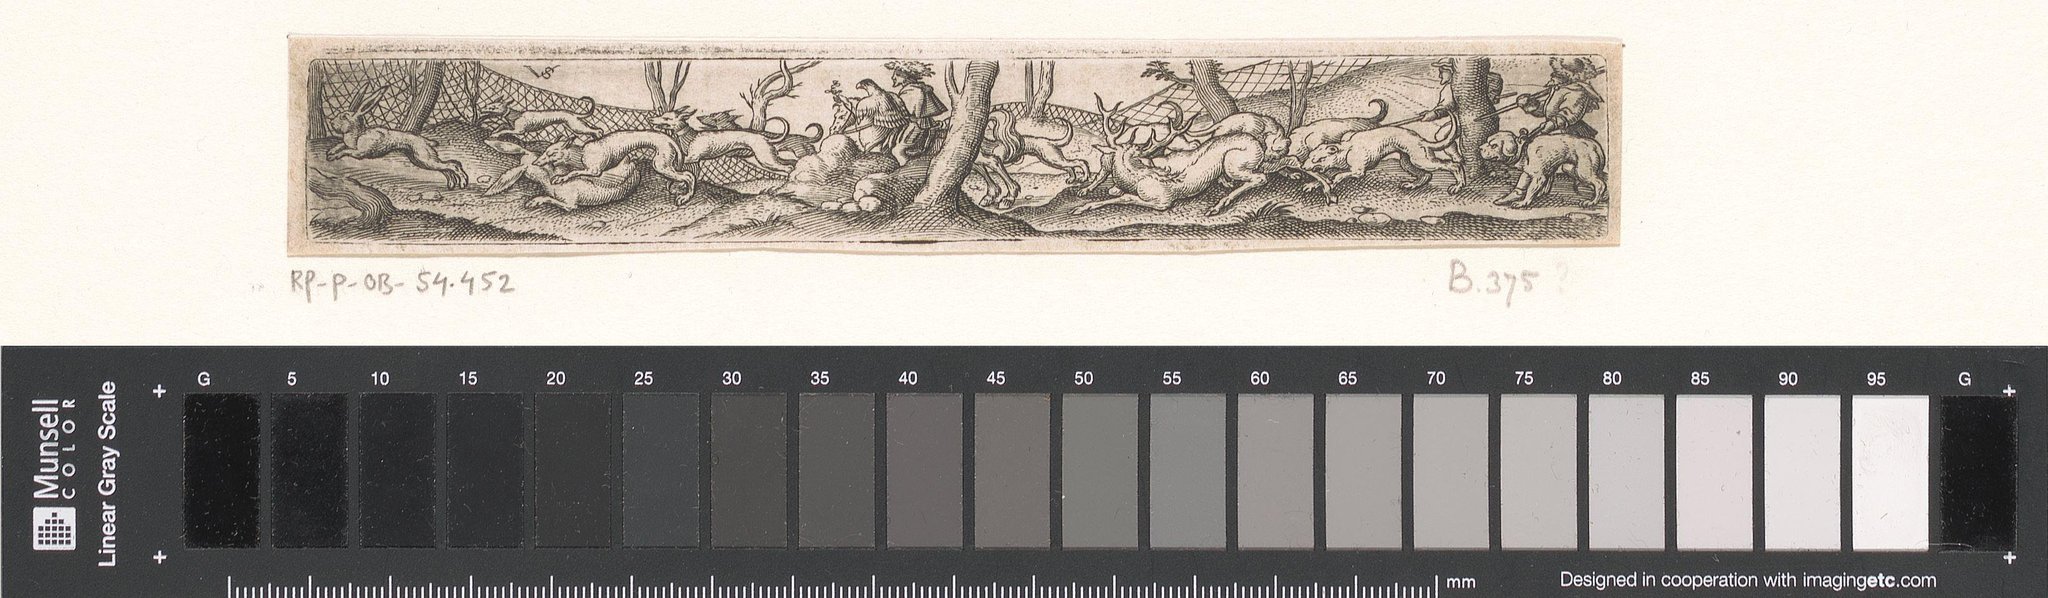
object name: print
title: Hertenjacht en hazenjacht en een valkenier te paard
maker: virgilius solis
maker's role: draughtsman, print maker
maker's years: 1514-1562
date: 1524-1562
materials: paper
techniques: engraving, etching, intaglio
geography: nuremberg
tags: riding a horse, ass, or mule; rider, horseman, predatory birds: falcon, stag-hunting, hare-hunting, rabbit-hunting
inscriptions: number: ‘28’, collector's mark: Lugt 2228